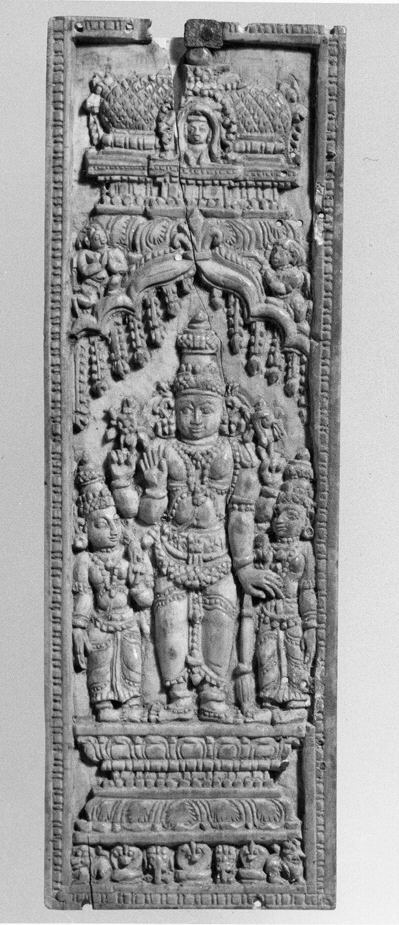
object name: plaque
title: Vishnu Standing between His Consorts, Lakshmi and Sarasvati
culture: tamil nadu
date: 1601-1800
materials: ivory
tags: goddess,vishnu,hinduism